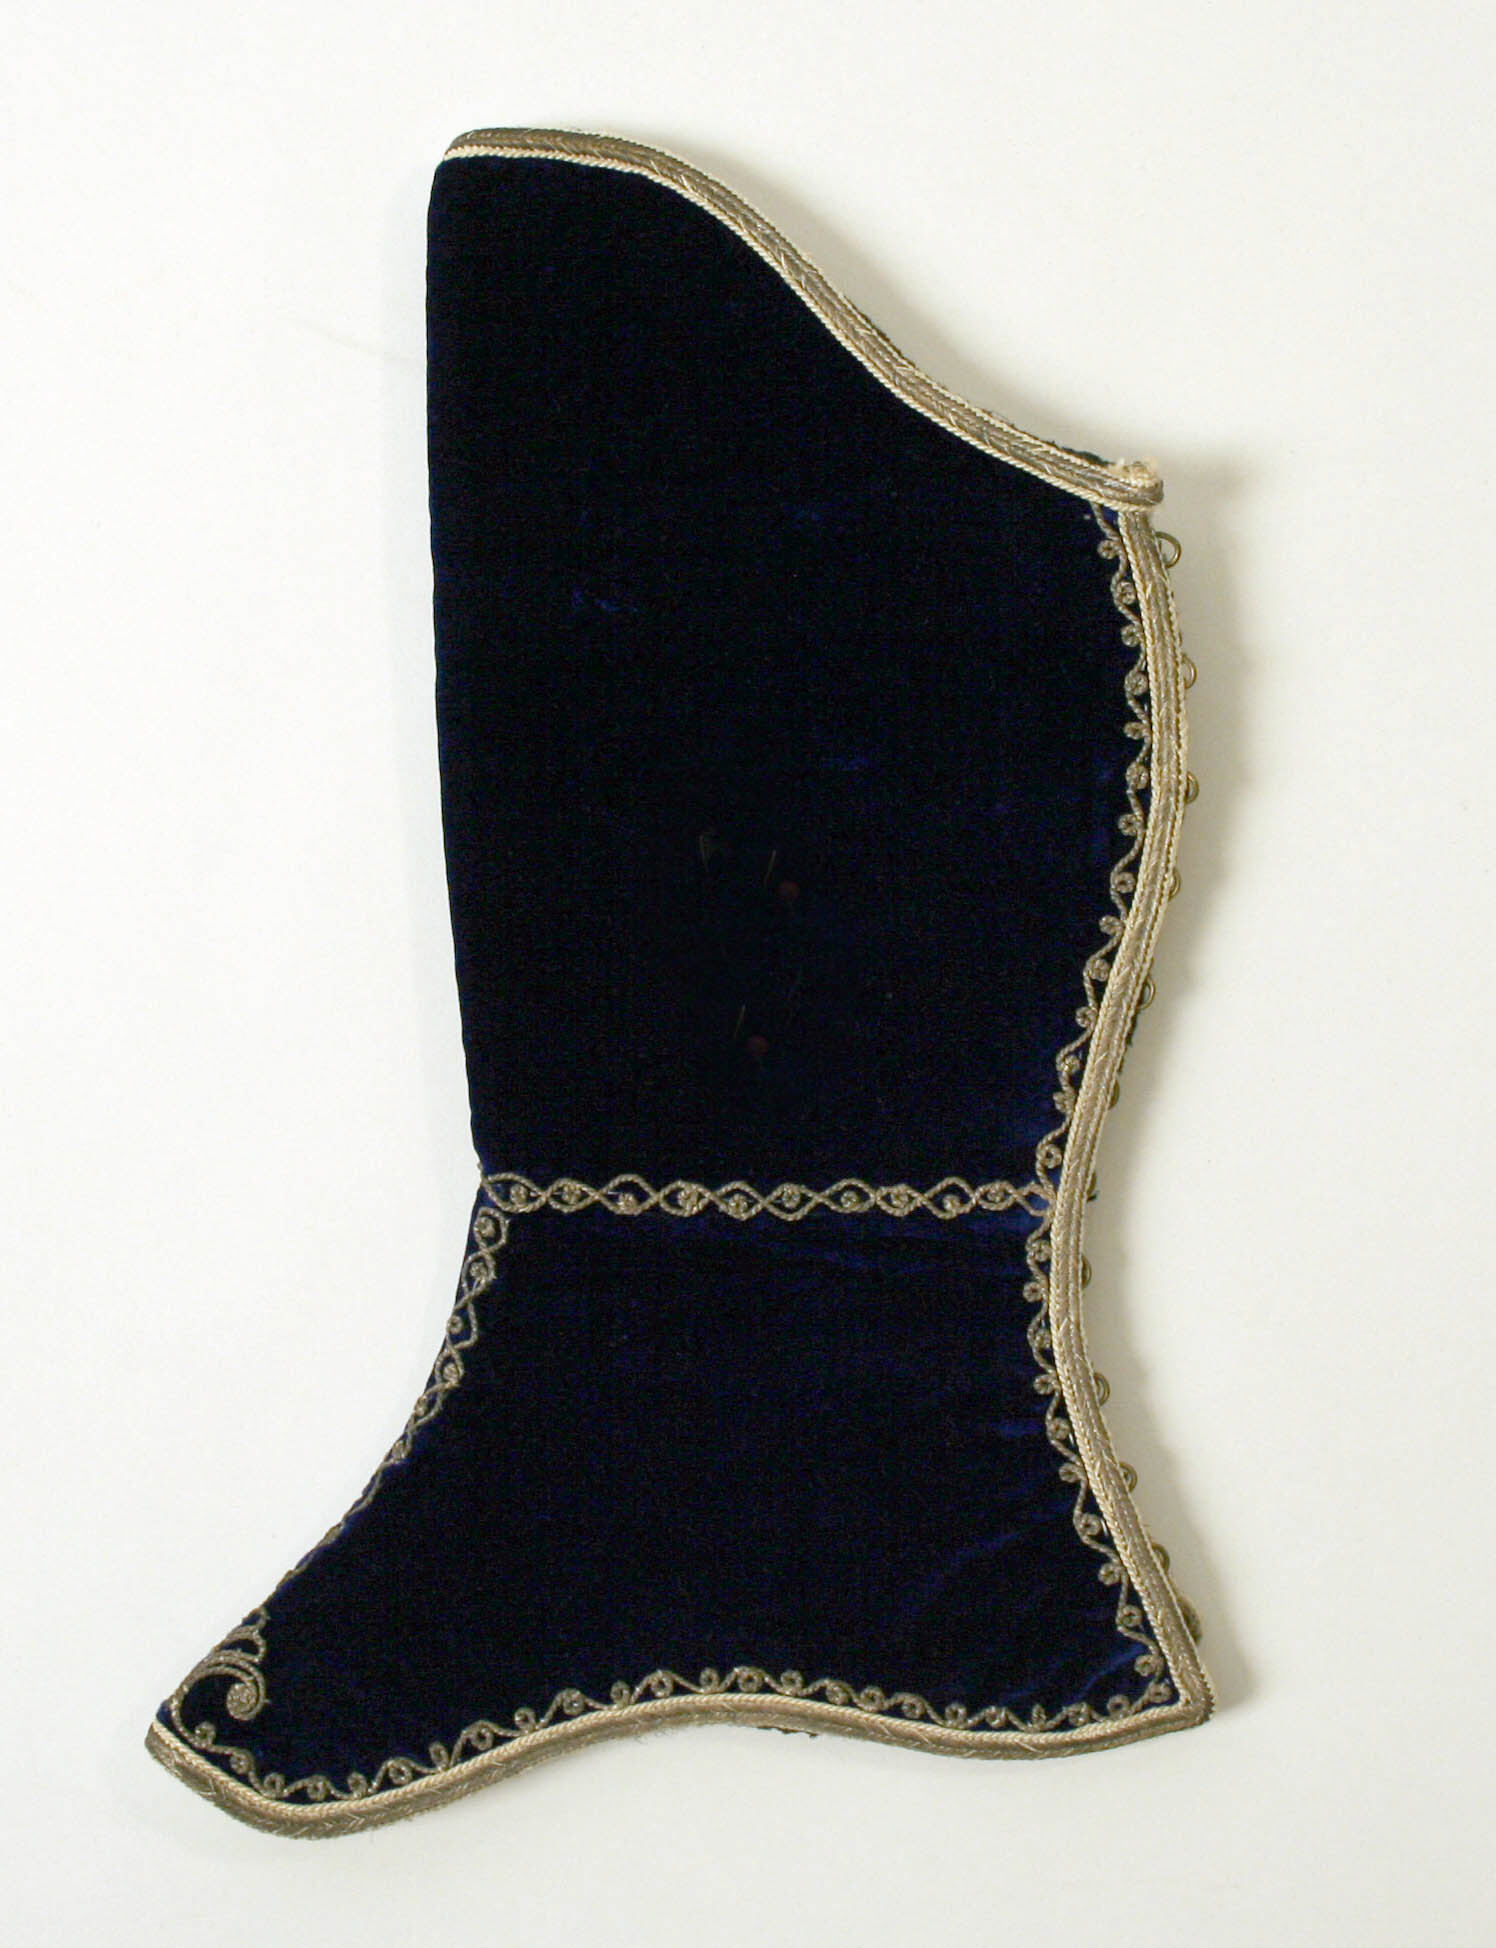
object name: gaiter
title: Gaiters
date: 1882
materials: metal, silk, wool